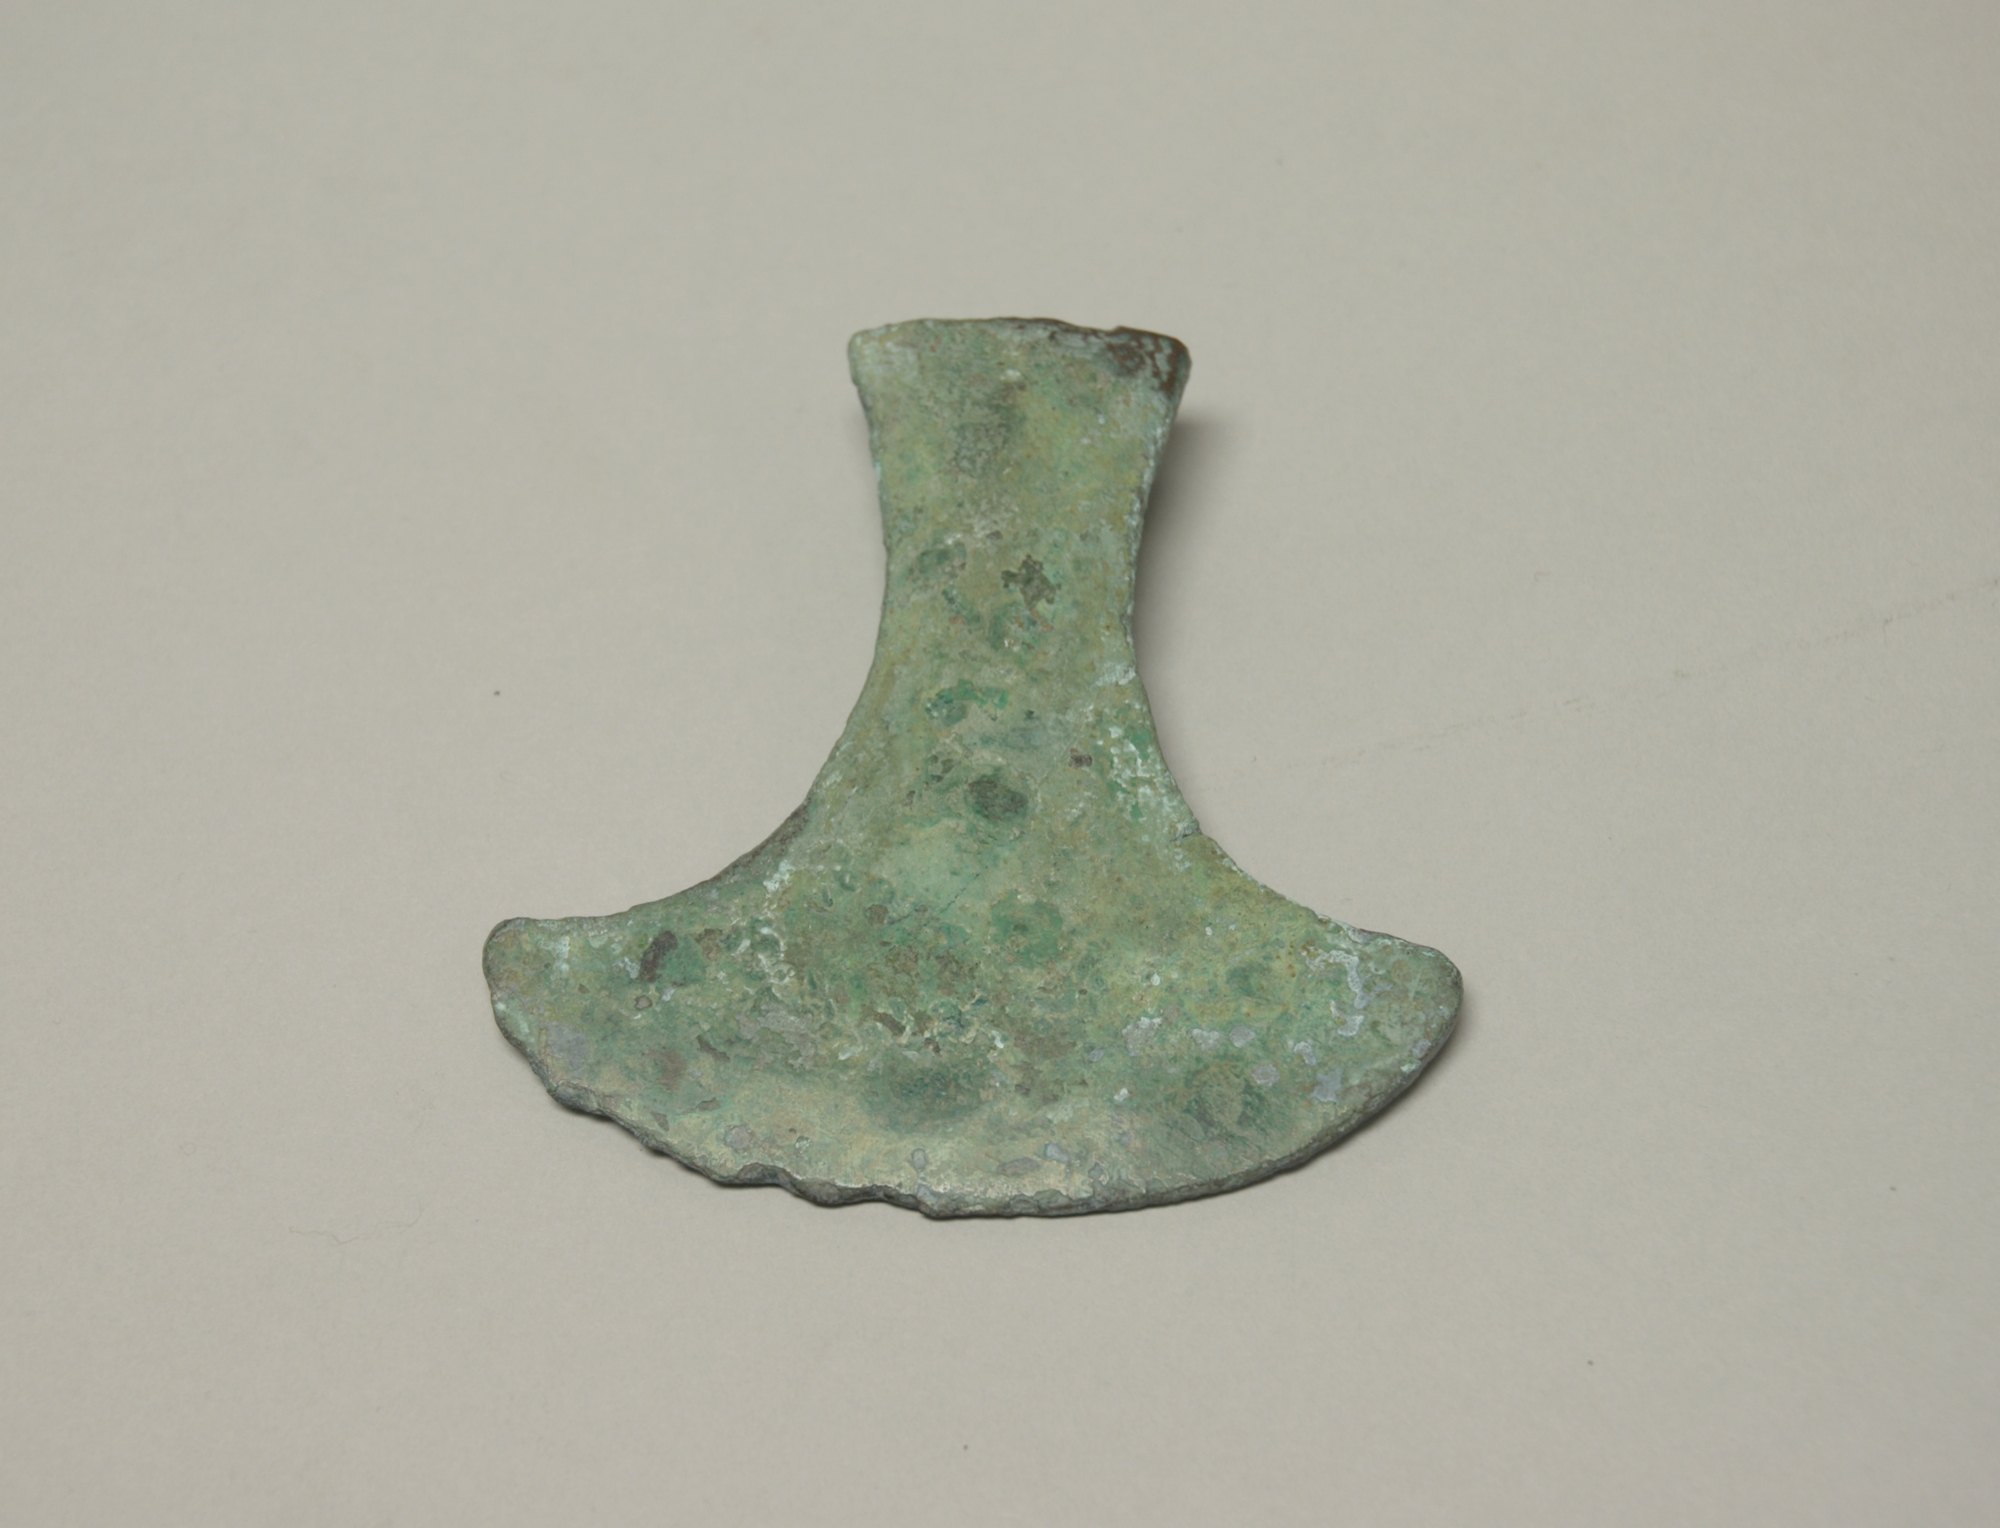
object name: hafted ax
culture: indonesian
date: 500 BCE-300 CE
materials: bronze